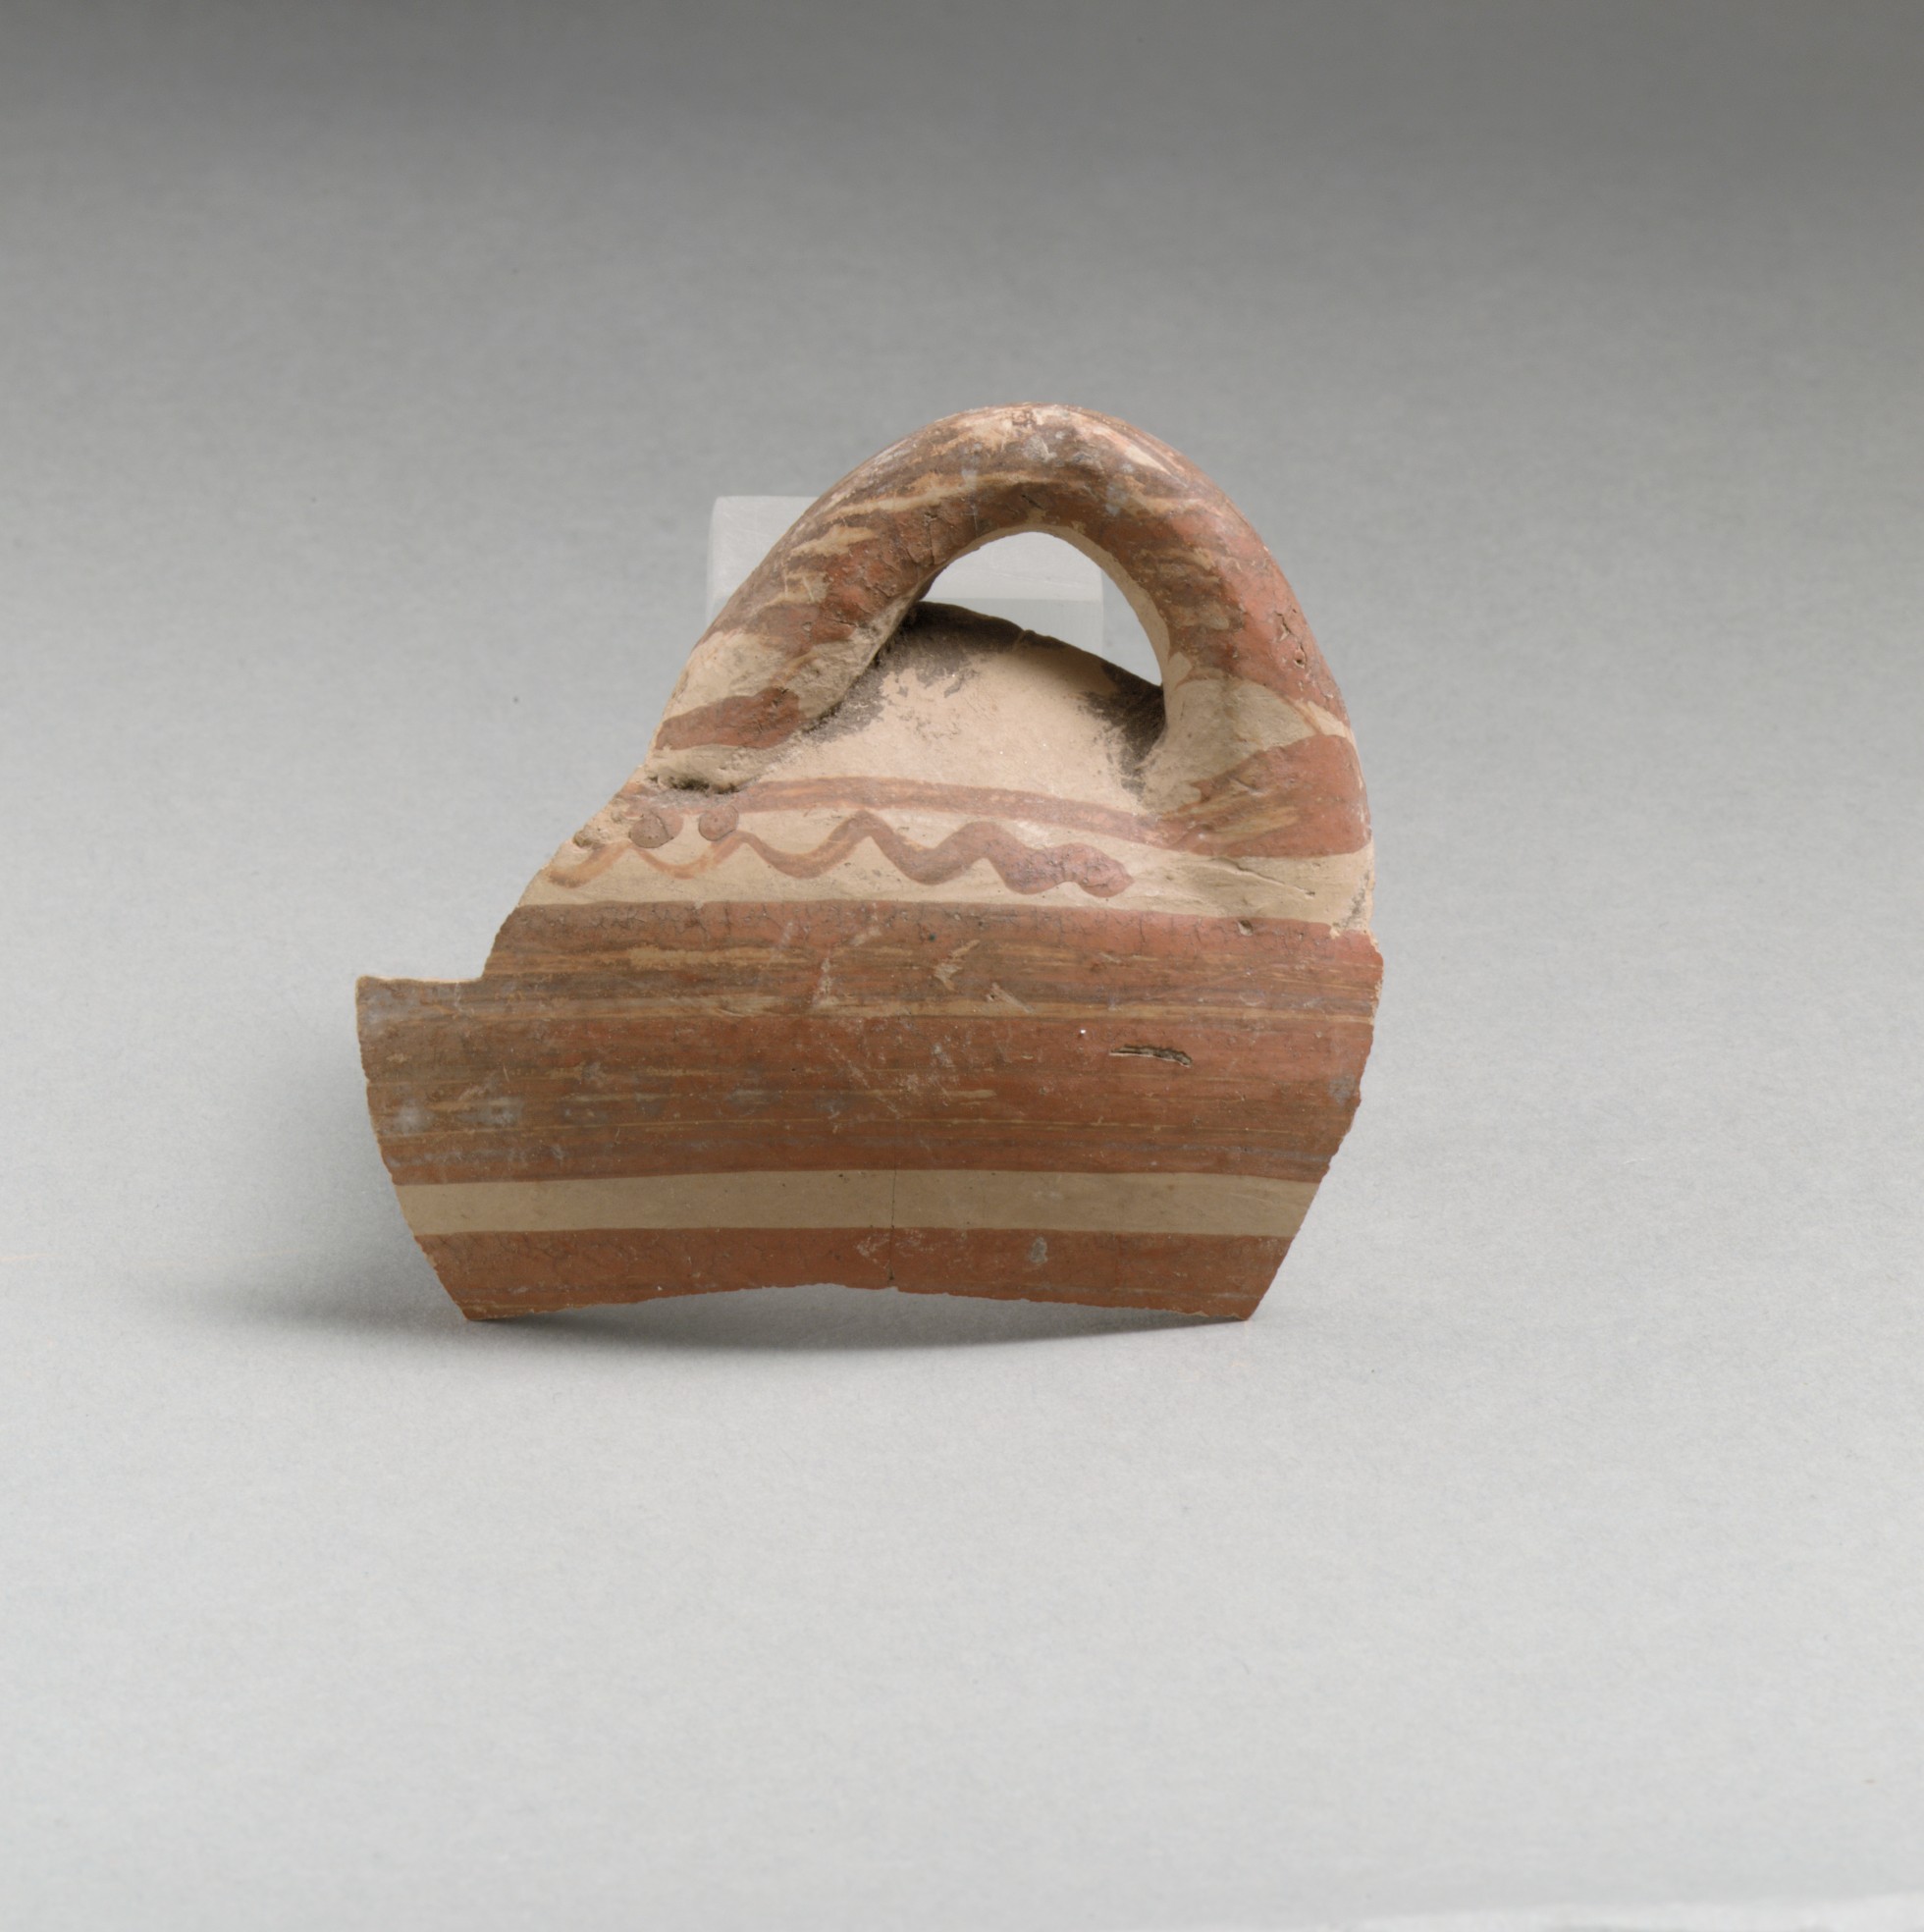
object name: vase fragment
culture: minoan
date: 1600-1450 BCE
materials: terracotta